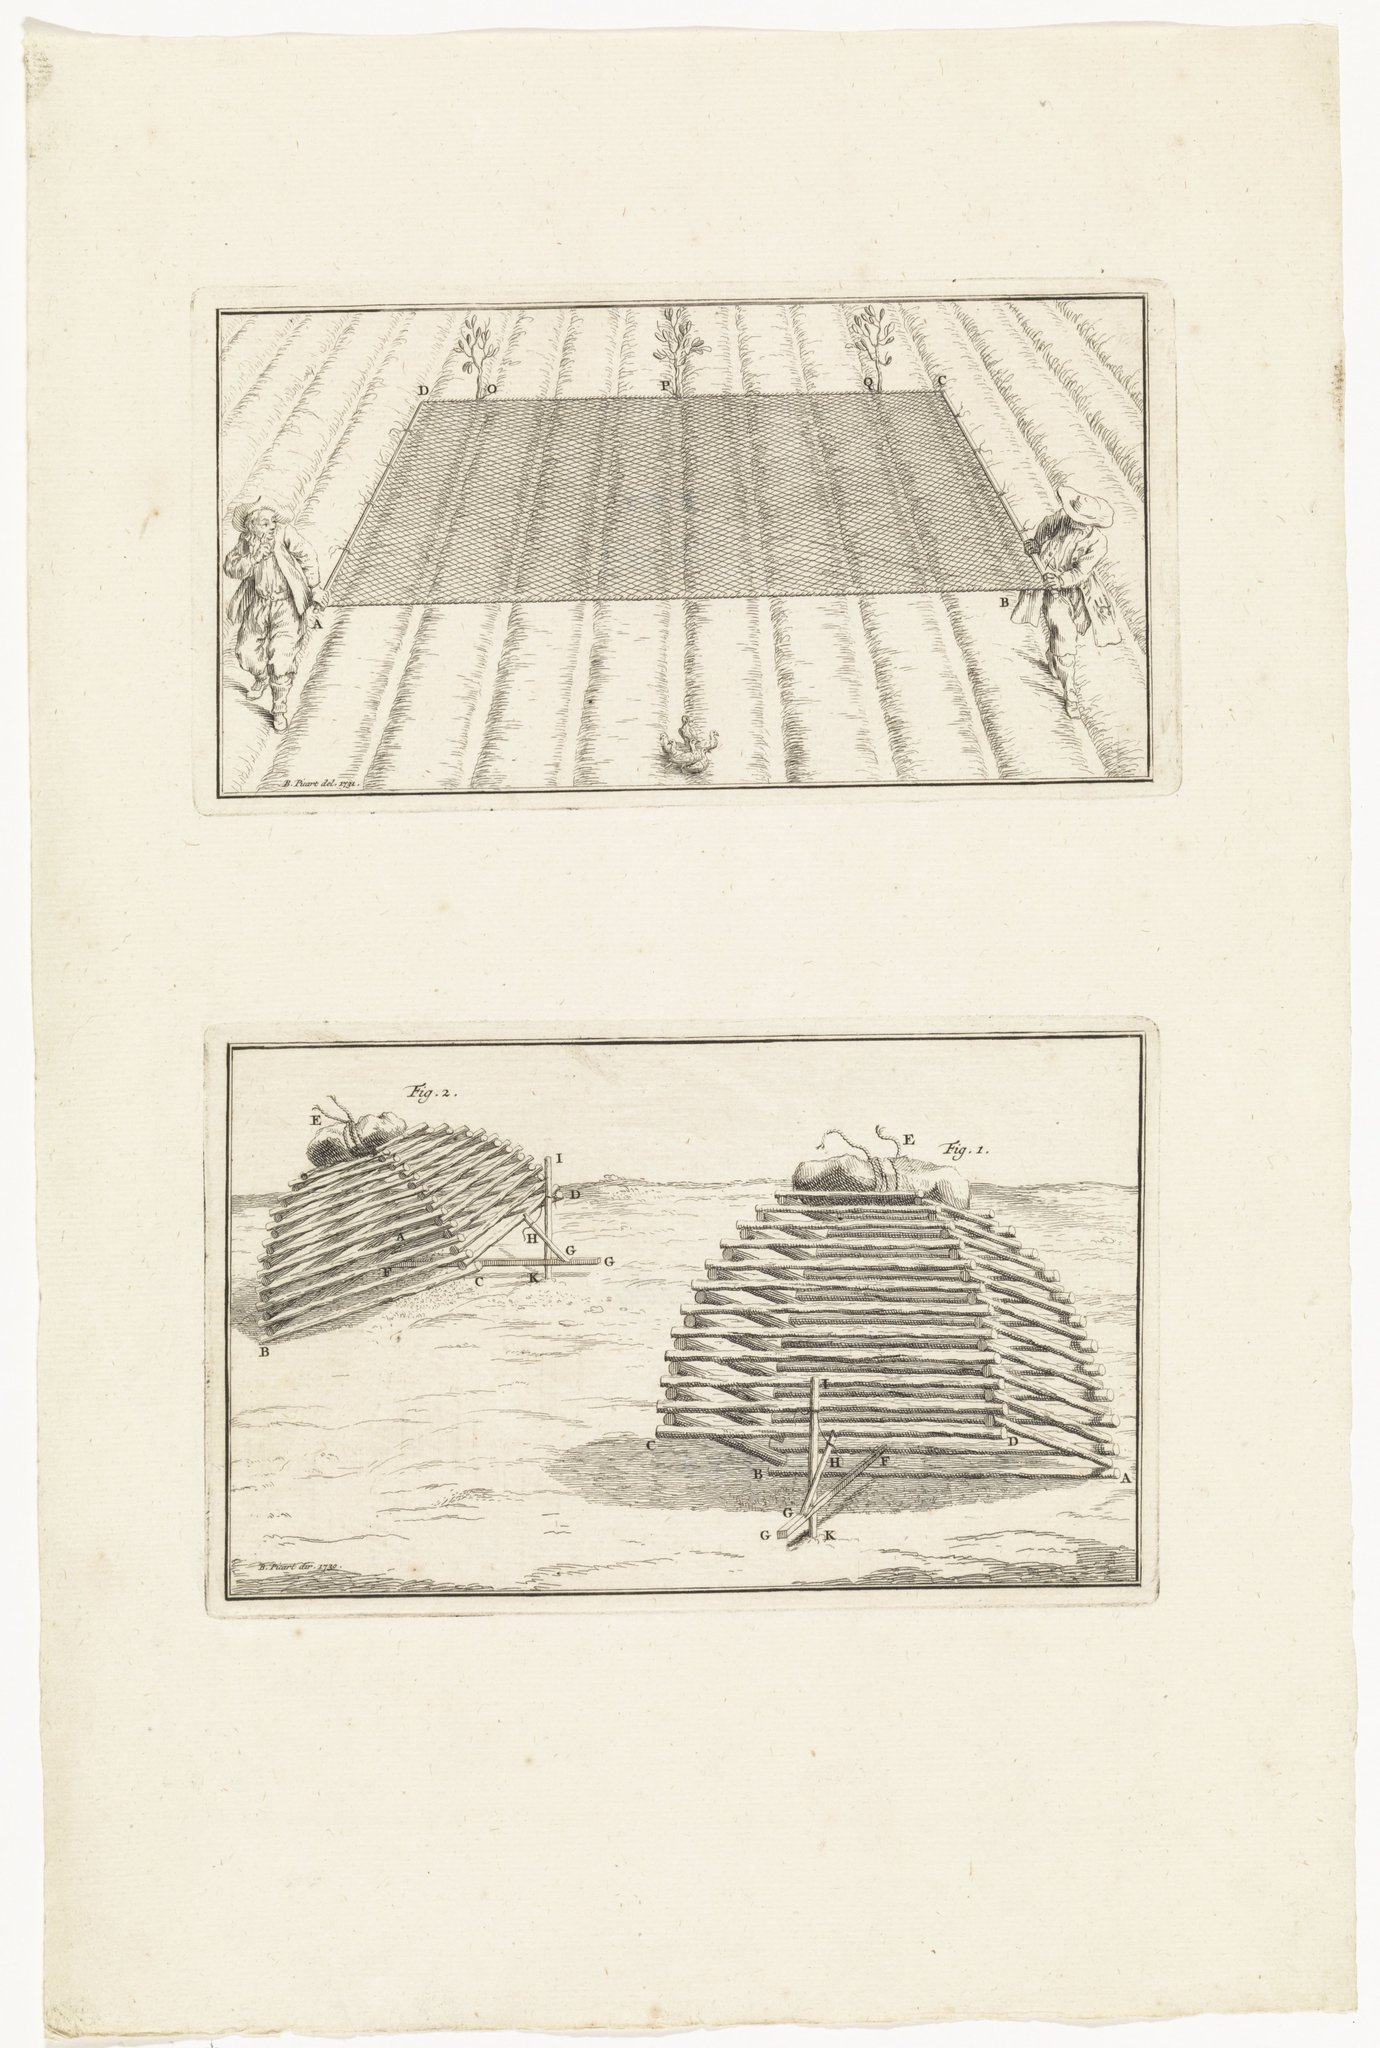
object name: print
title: Vangen van akkervogels en dierenvallen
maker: bernard picart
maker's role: draughtsman, print maker, publisher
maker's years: 1673-1733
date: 1730-1731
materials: paper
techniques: etching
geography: amsterdam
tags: bird hunting, catching animals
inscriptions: collector's mark: Lugt 2233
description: Prenten bedoeld voor: Chomel, Noel. Dictionnaire oeconomique, contenant divers moïens d'augmenter son bien, et de conserver sa santé. Amsterdam: Johannes Covens en Cornelis Mortier, 1732.